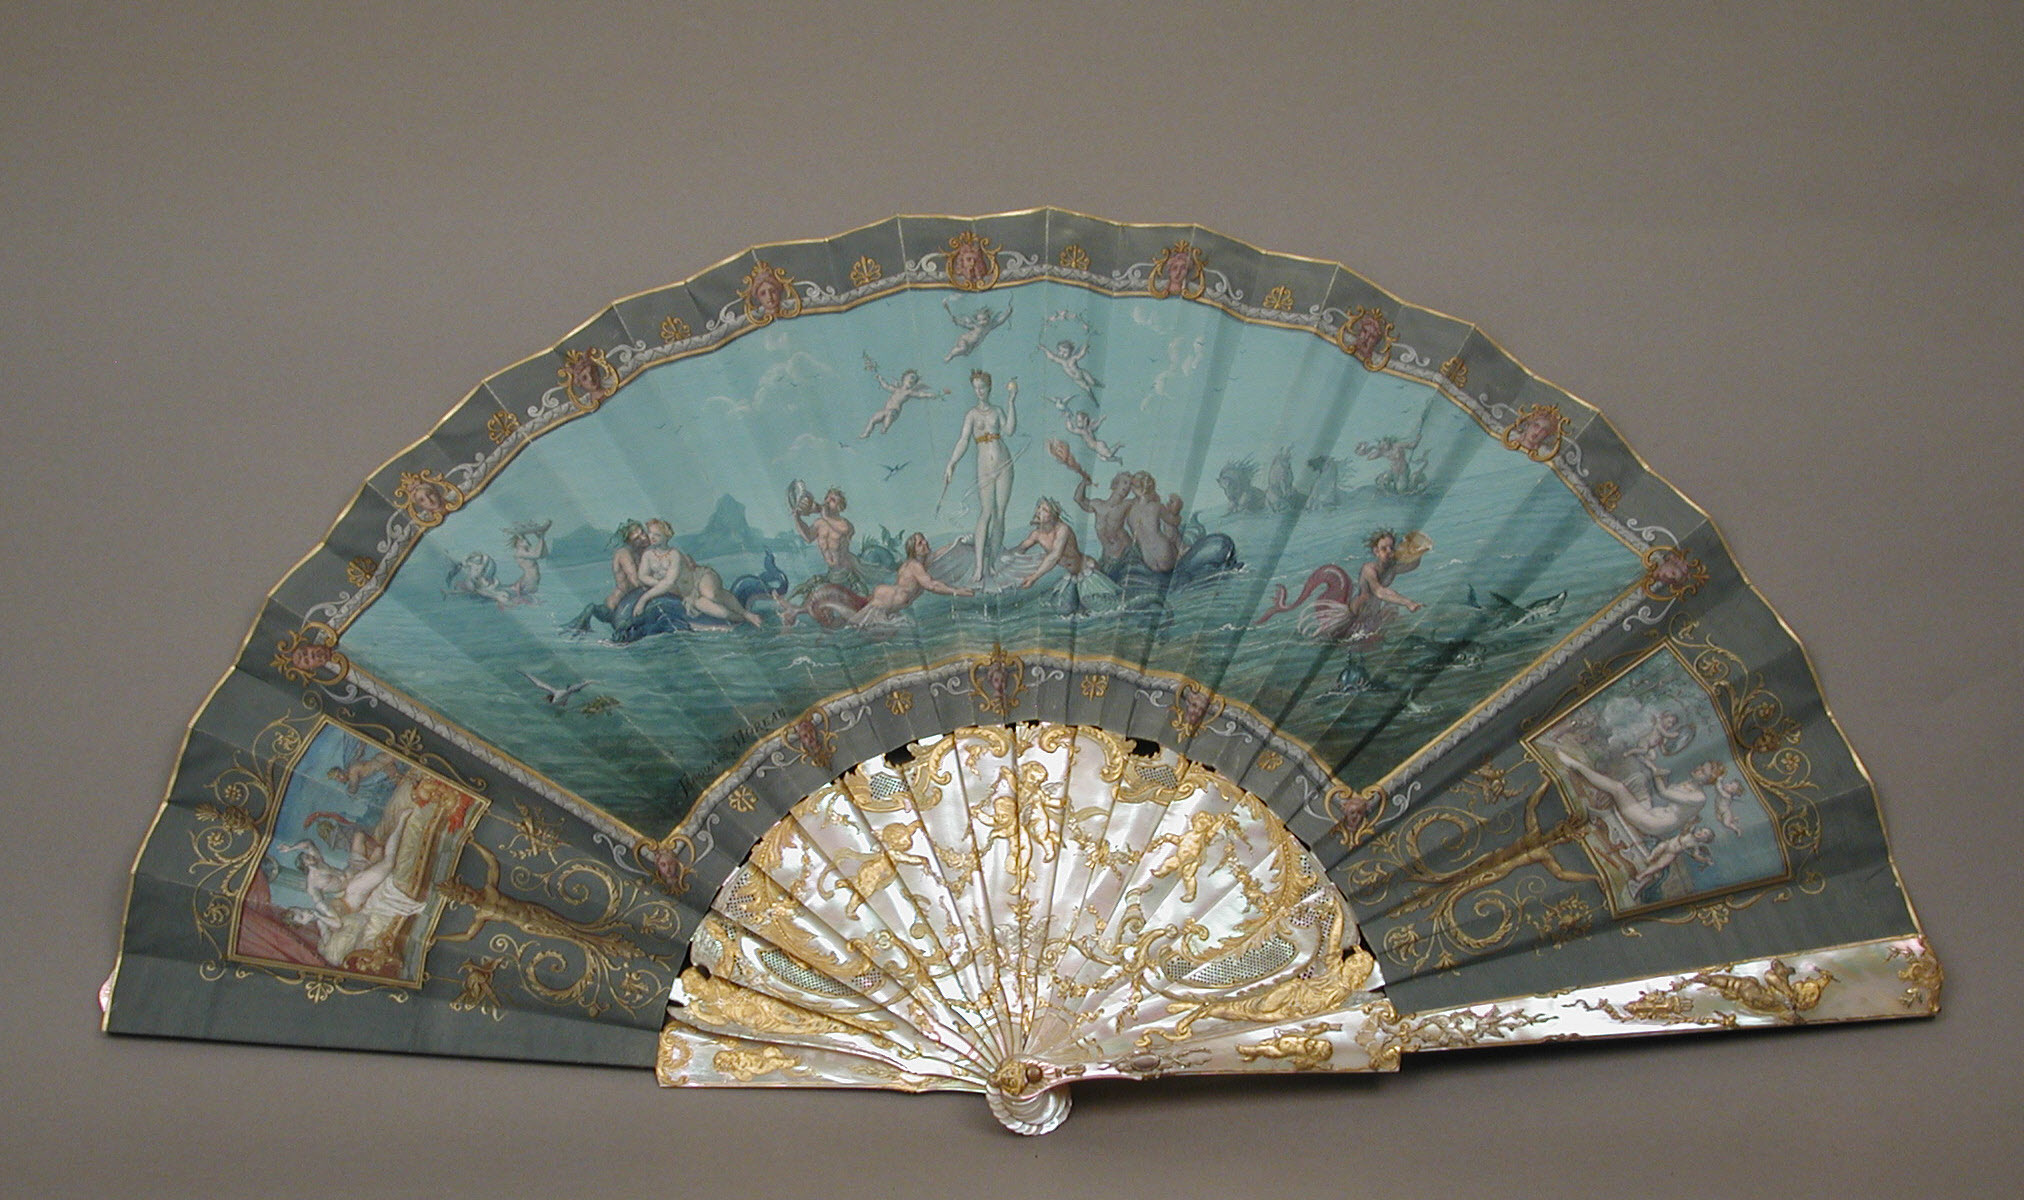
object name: fan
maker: edouard moreau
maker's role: designer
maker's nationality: french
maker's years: 1825-1878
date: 1860-1875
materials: metal, mother of pearl, paint, paper, parchment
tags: birds,female nudes,venus,fish